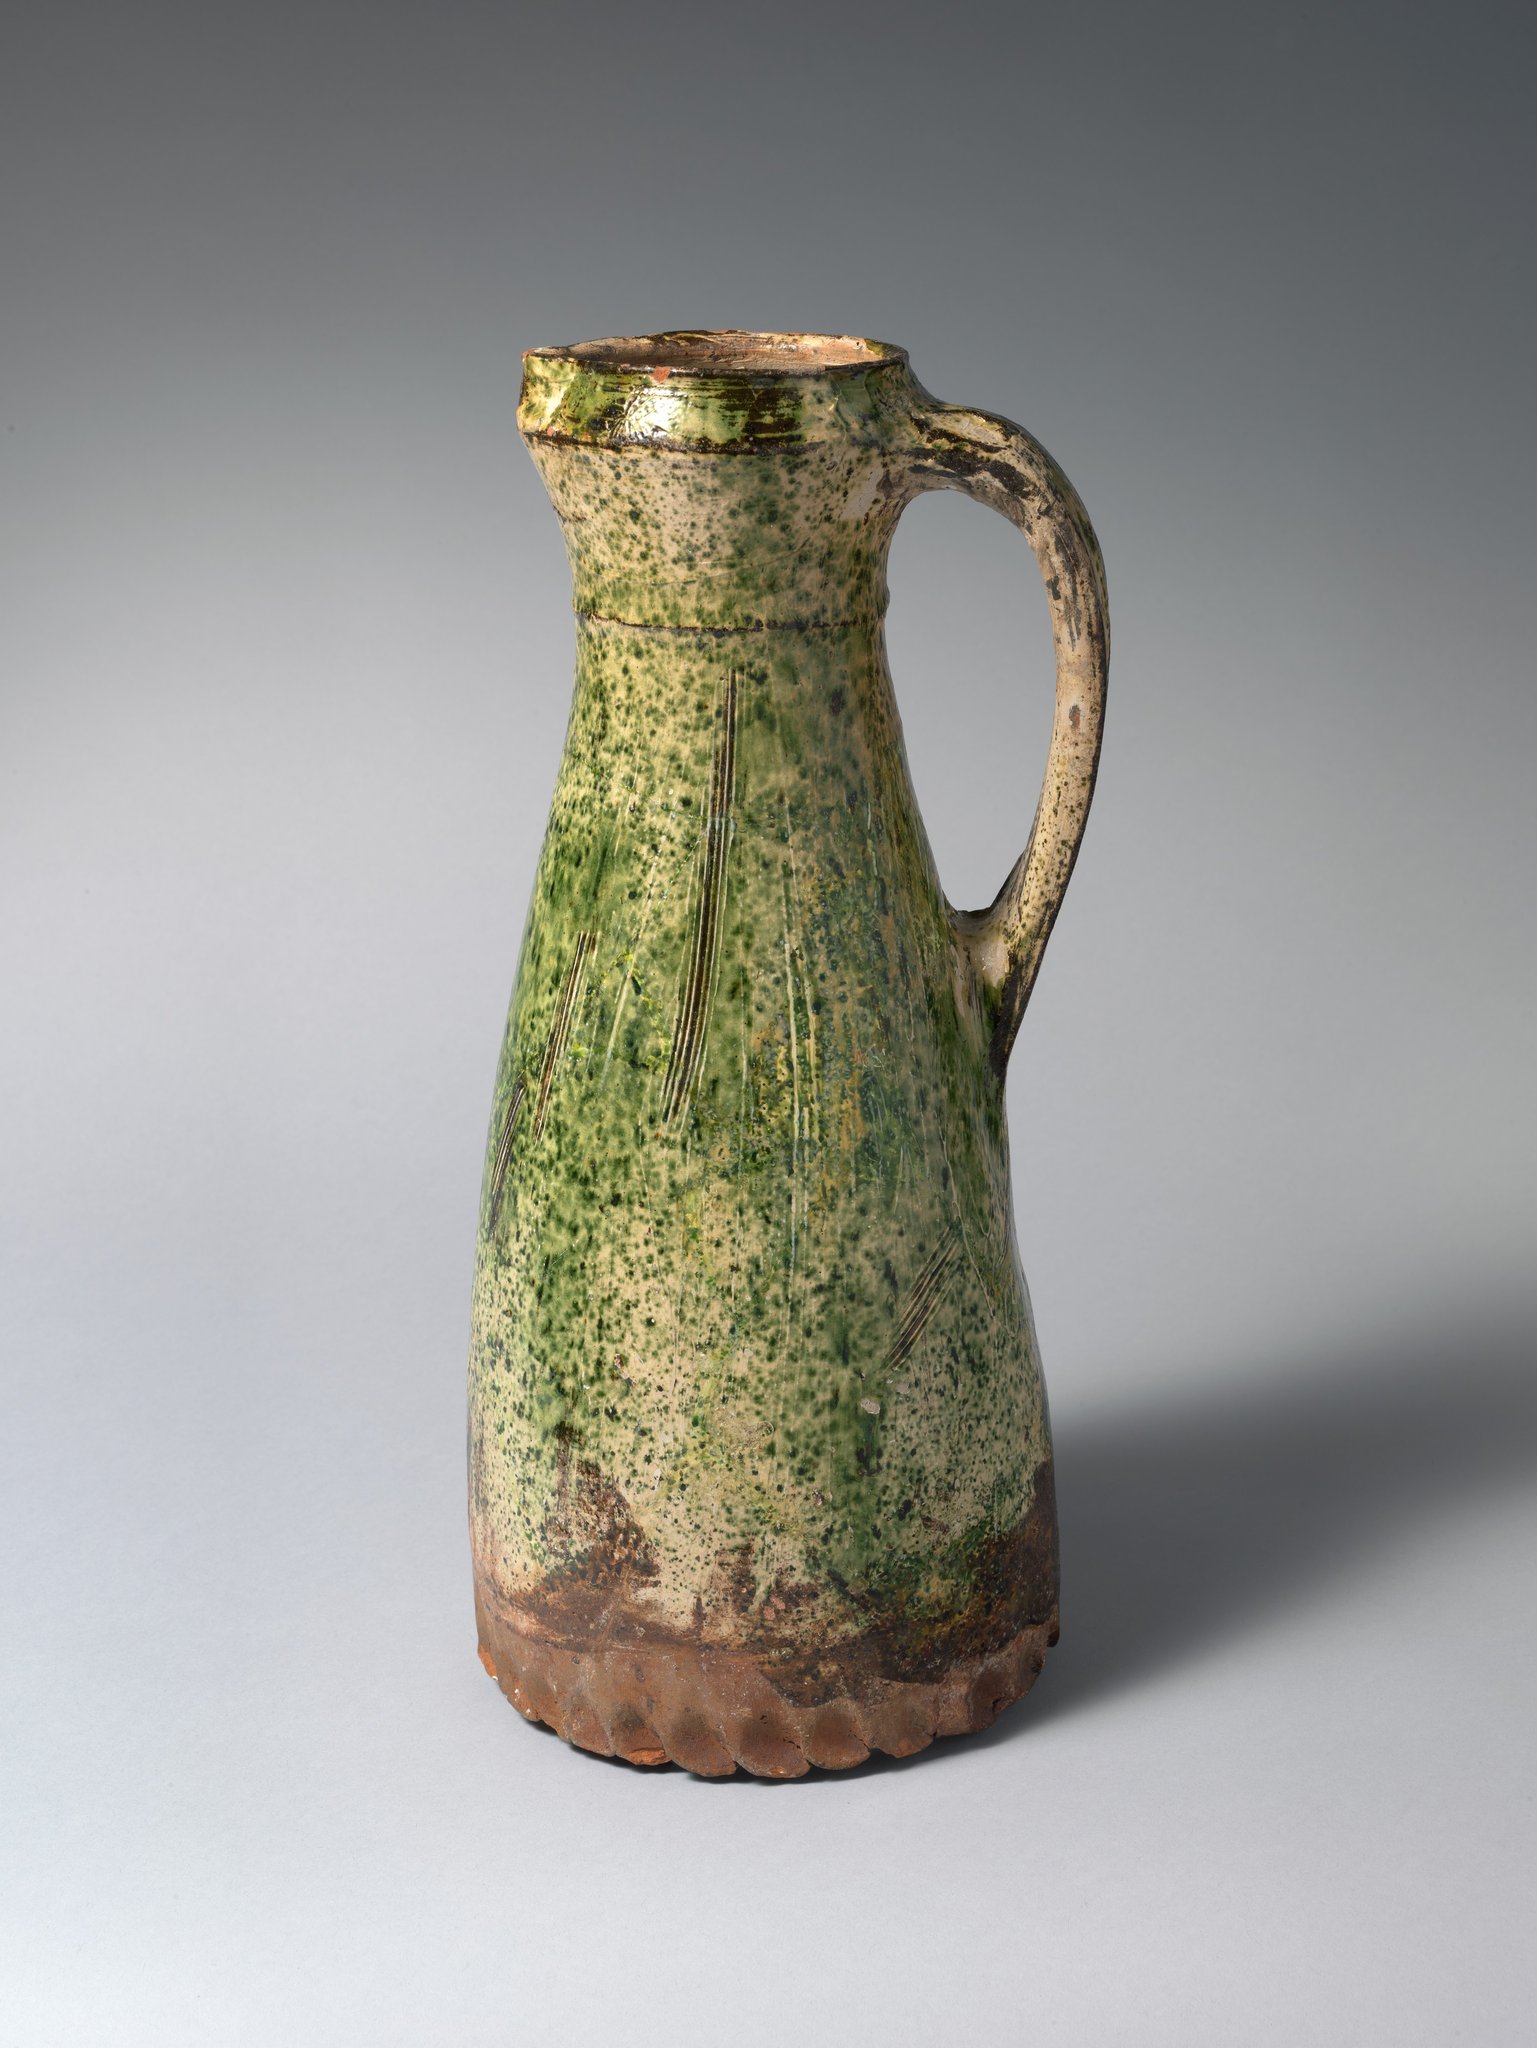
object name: jug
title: Green Glazed Jug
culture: british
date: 1301-1400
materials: earthenware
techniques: glazing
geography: england